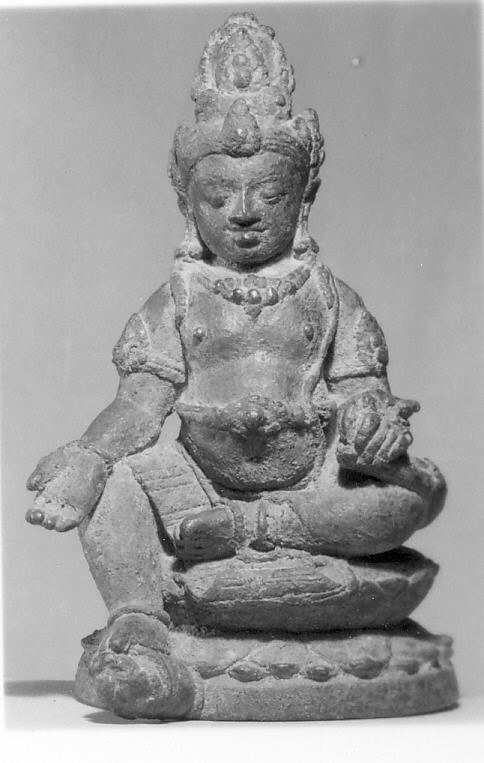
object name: figure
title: Seated Kuvera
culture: indonesian, javanese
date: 801-900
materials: bronze